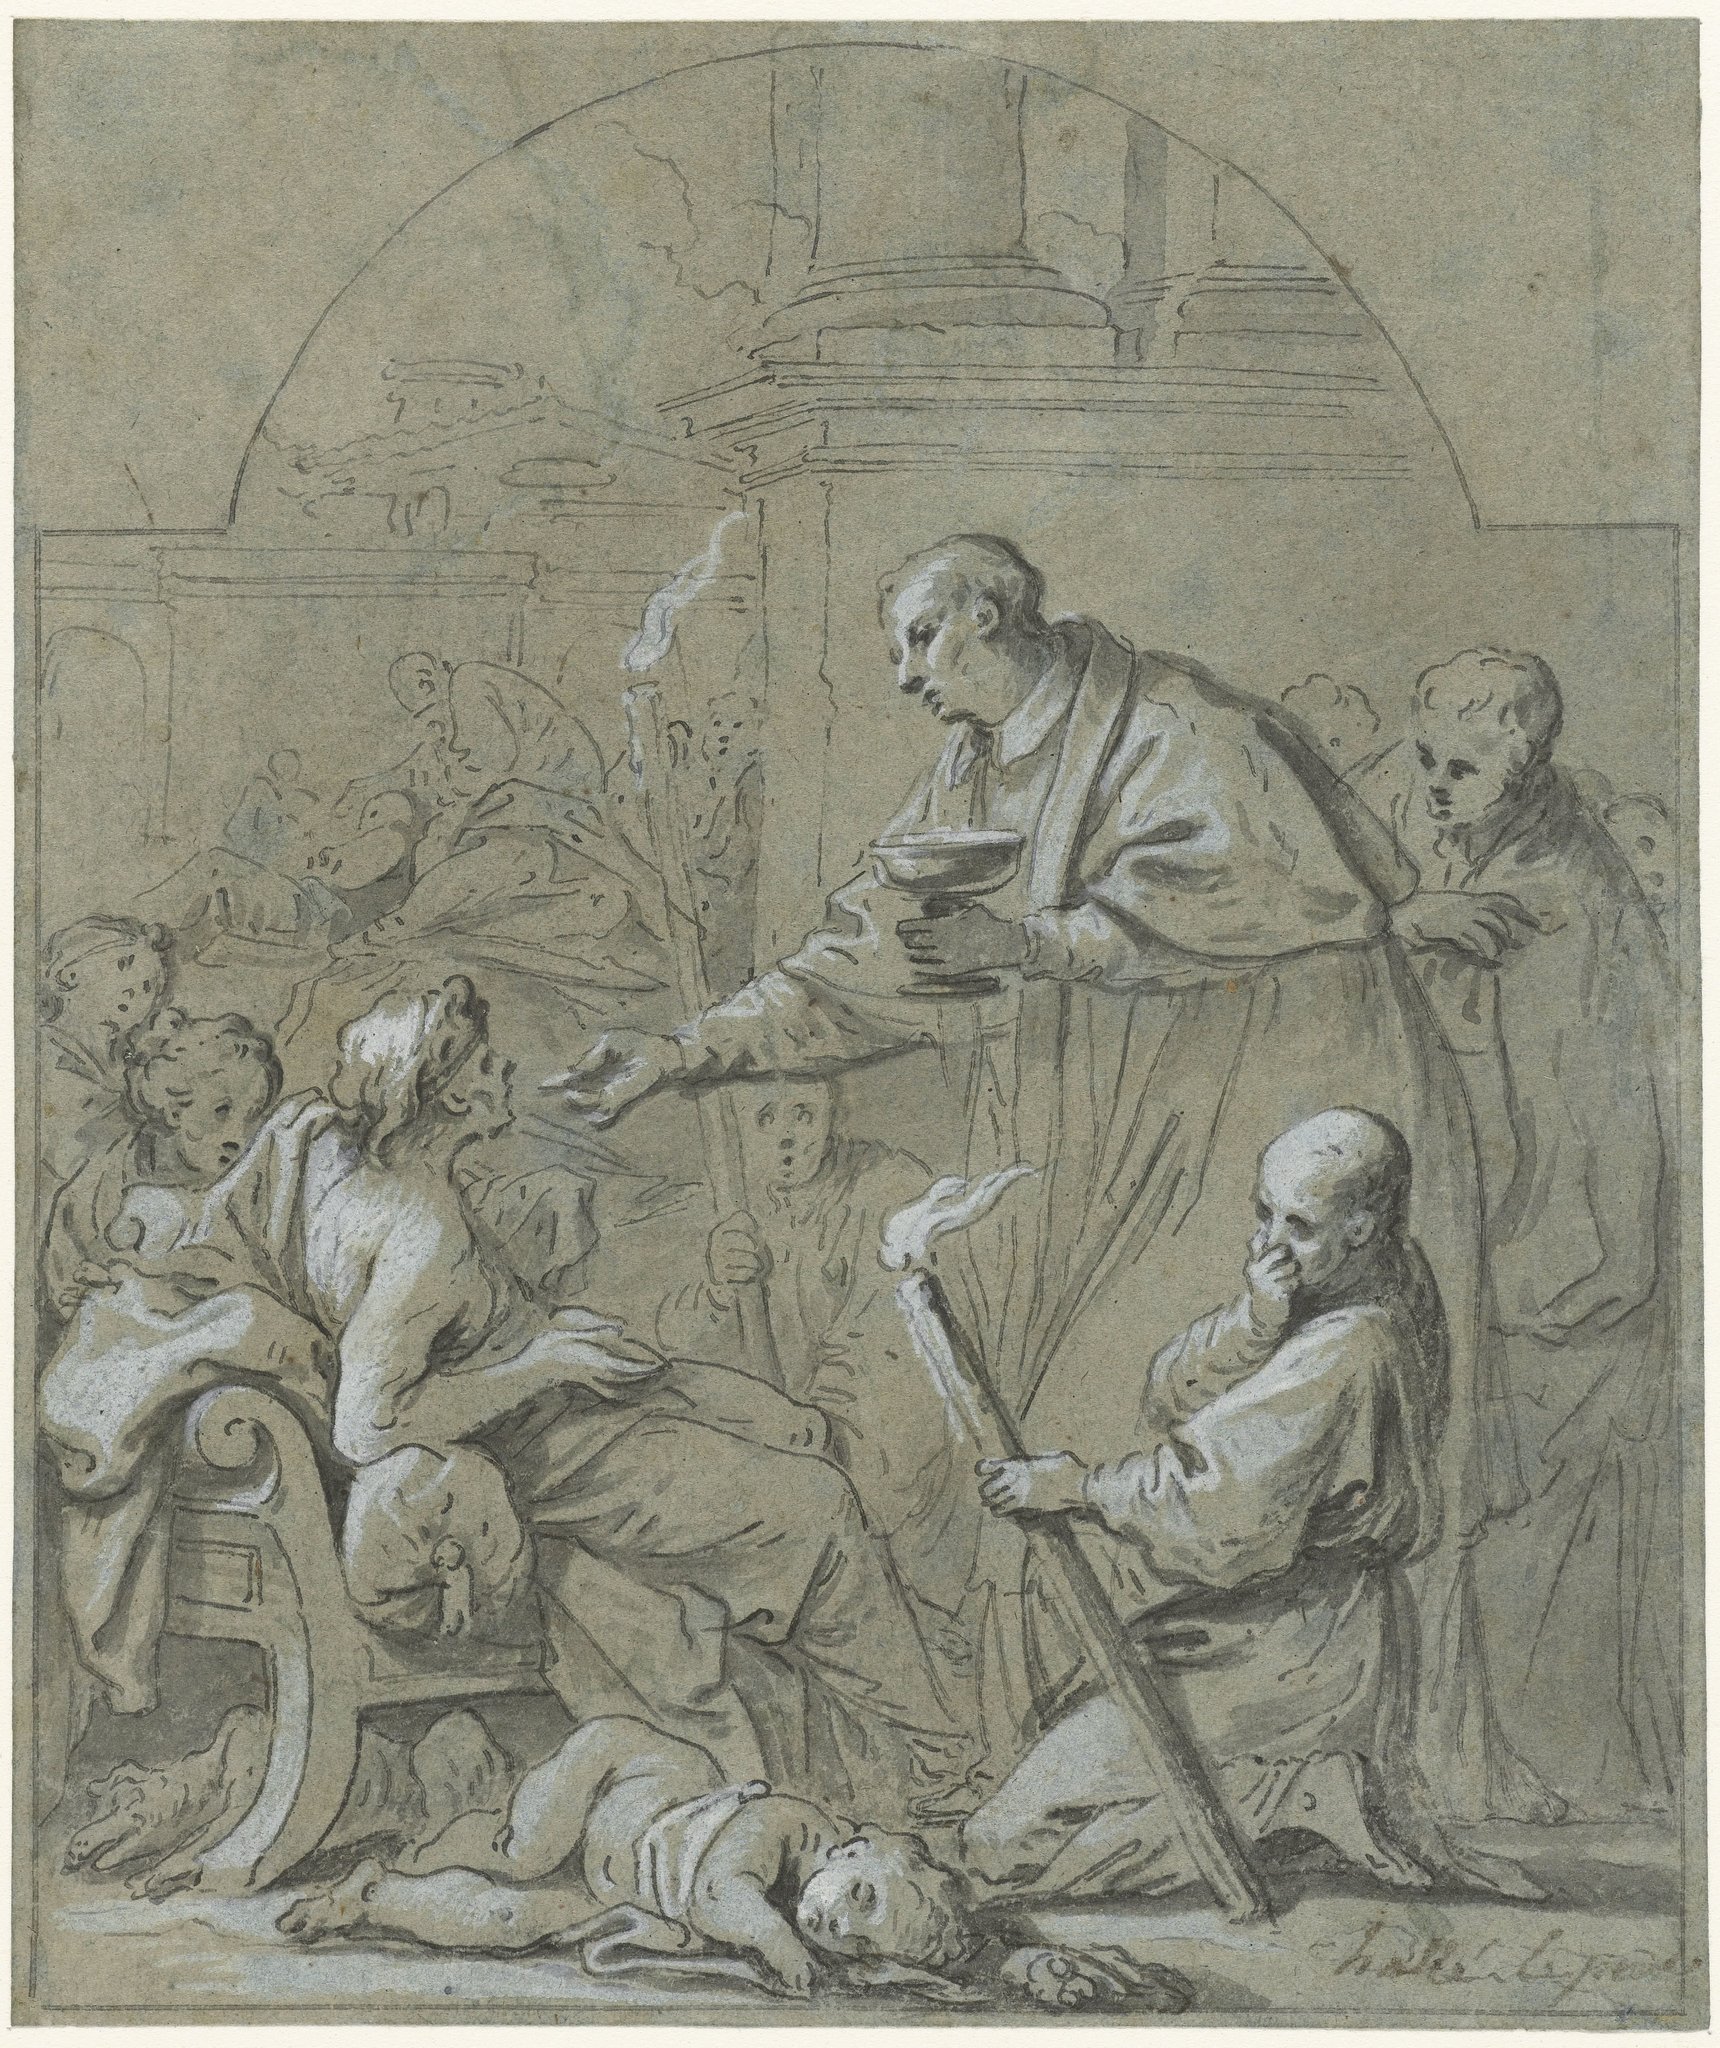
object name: drawing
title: Heilige Carolus Borromeus geeft pestlijders de laatste Communie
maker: claude guy hallé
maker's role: draughtsman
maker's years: 1652-1736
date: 1662-1736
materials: ink, paper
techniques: brush, pen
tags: male saints (with name)